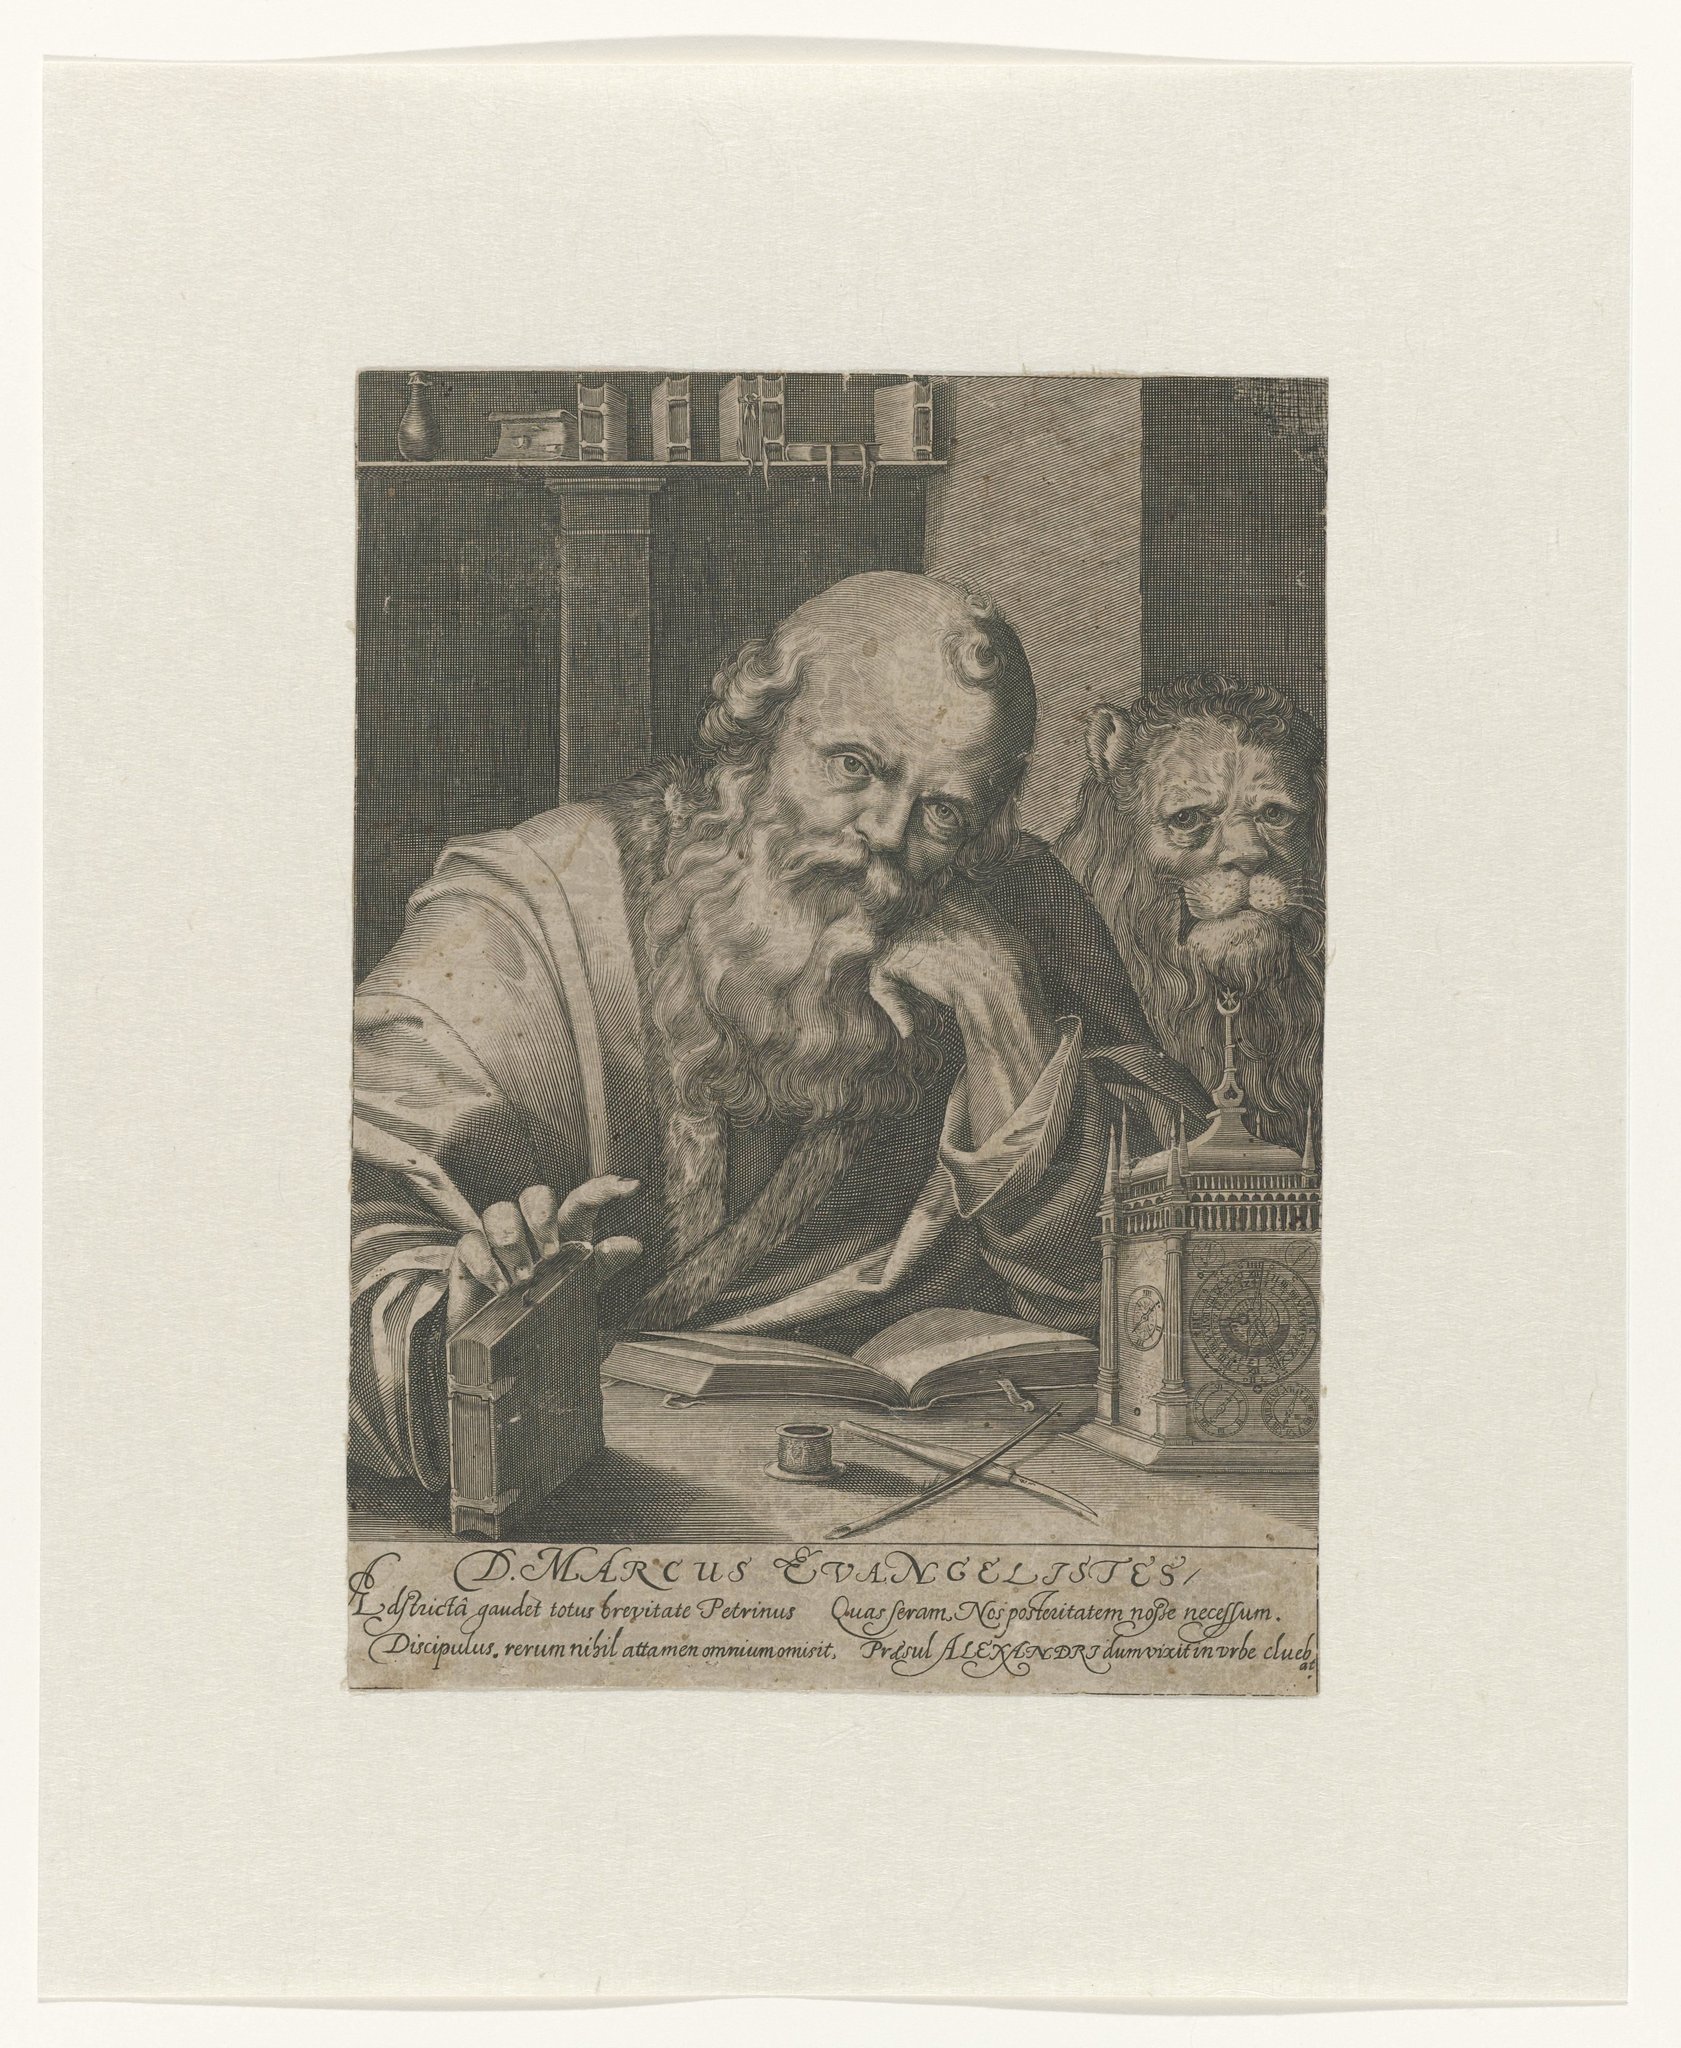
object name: print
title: Evangelist Marcus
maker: Anonymous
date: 1600-1630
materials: linen, paper, textile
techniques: engraving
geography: netherlands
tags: writing tools, mark (marcus) the evangelist, and bishop of alexandria; possible attributes: book, (winged) lion, pen and inkhorn, scroll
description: Marcus zit aan een tafel met voor hem een opengeslagen boek, een pen, inkt en en een uurwerk. Achter hem de leeuw. De prent is gemonteerd op een gebruikt stuk 17de-eeuws linnen.